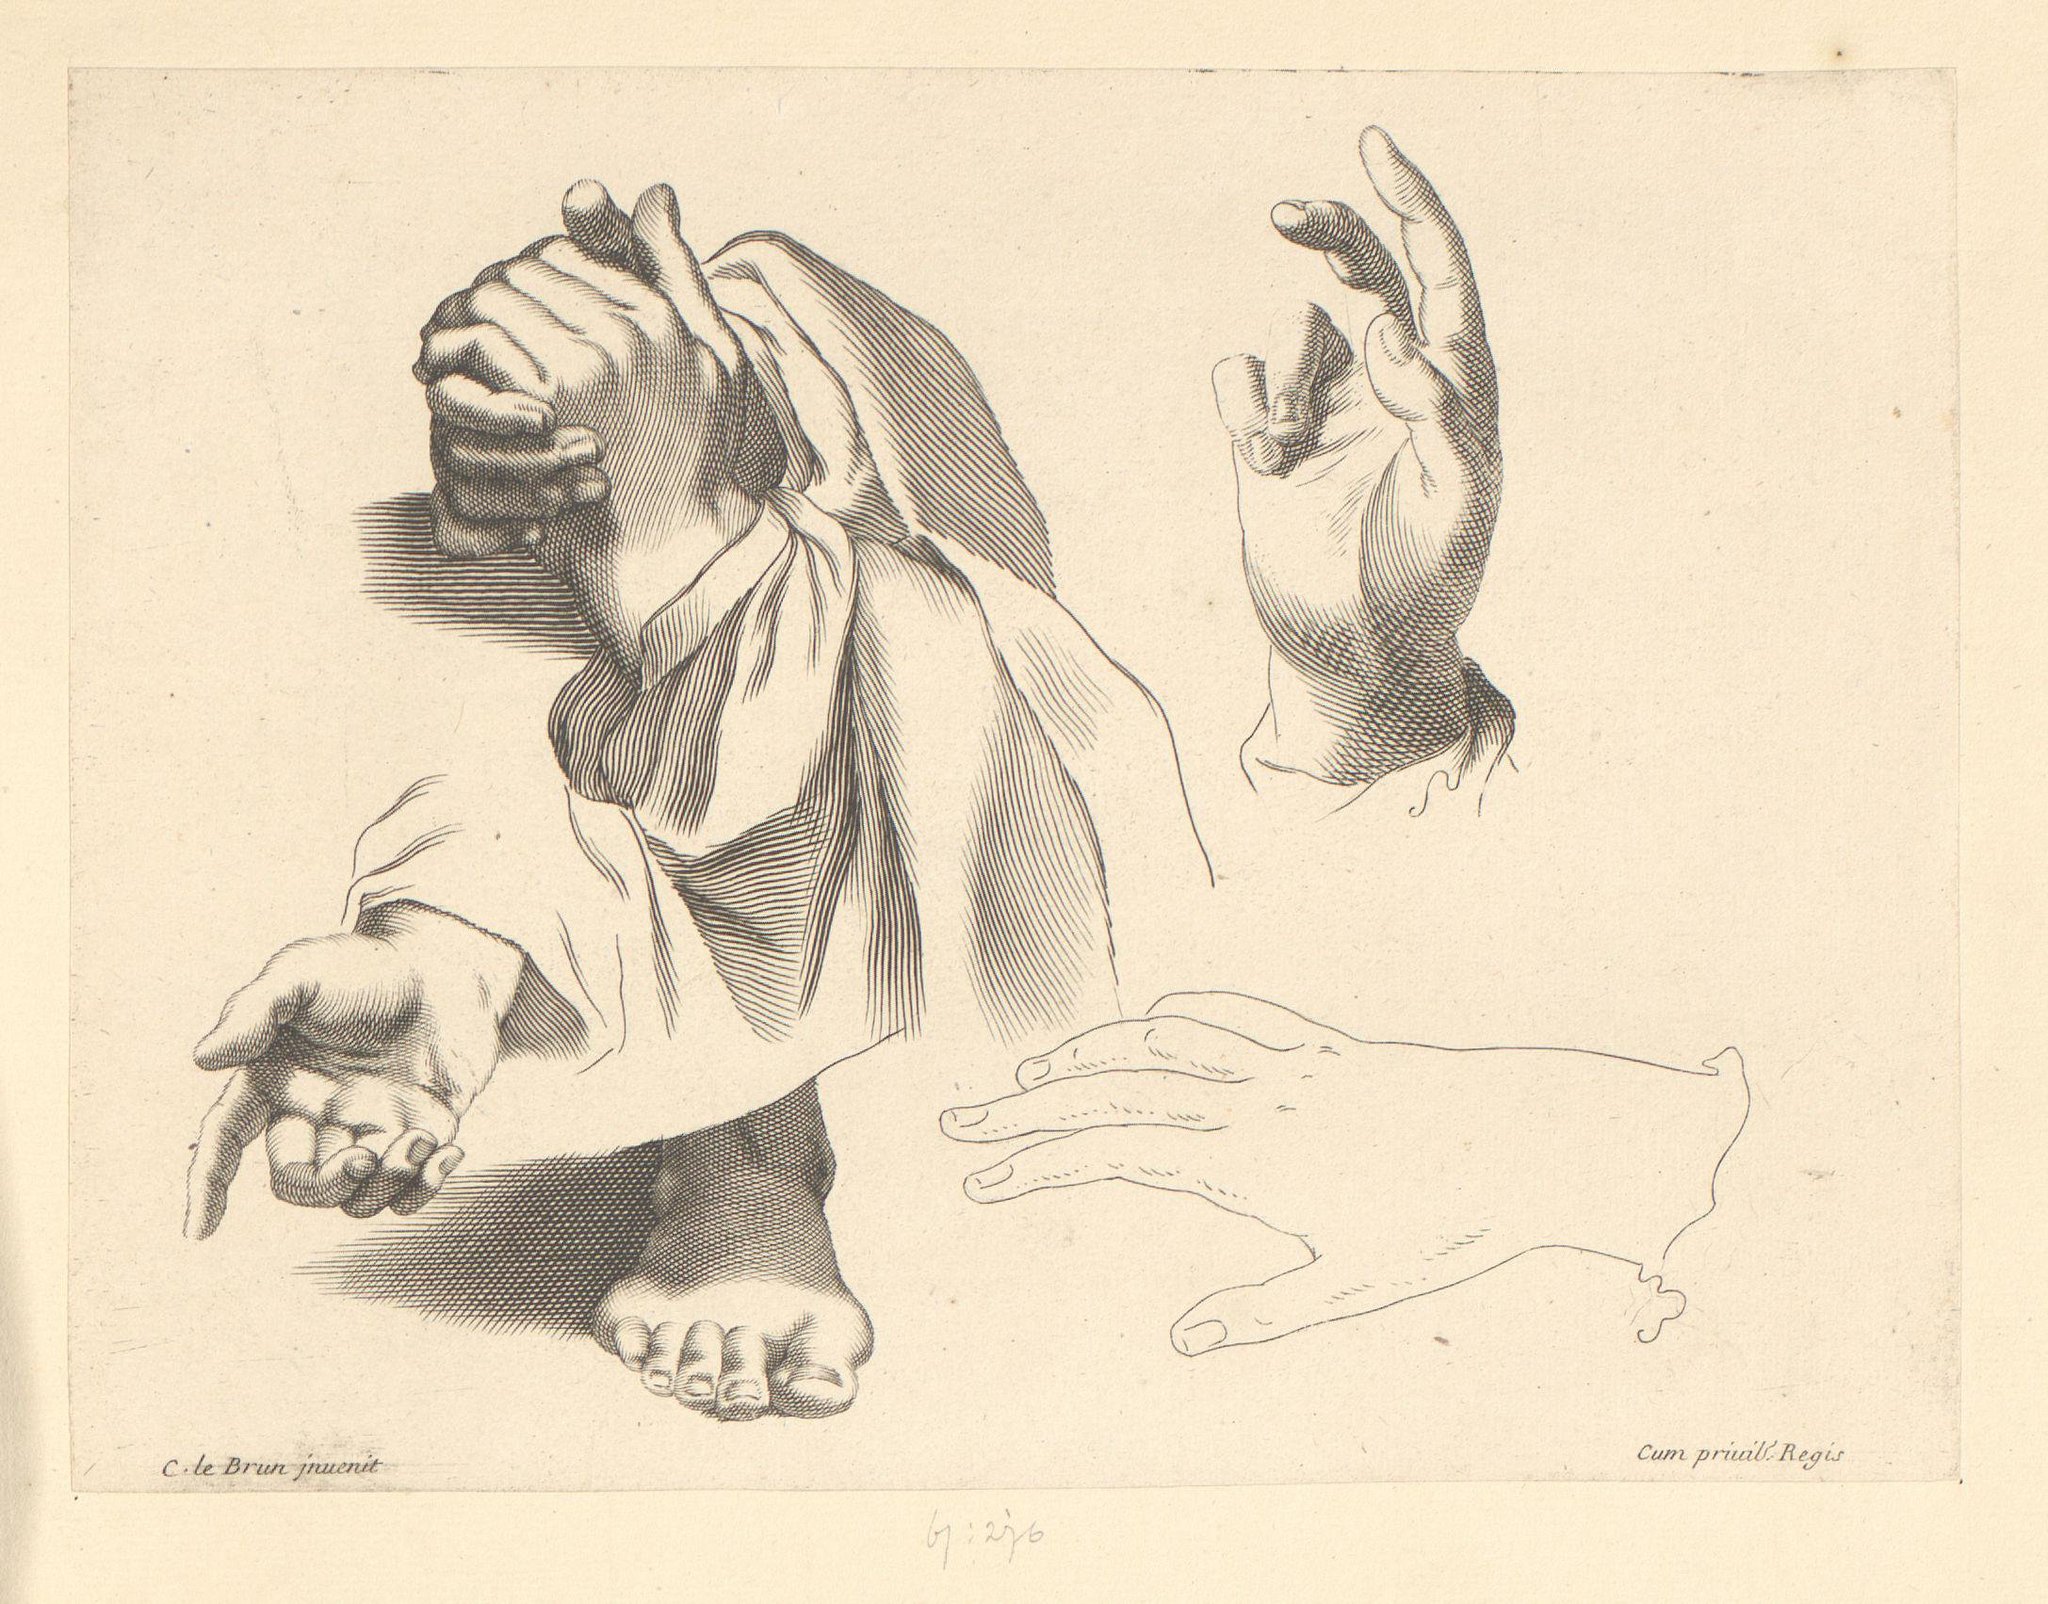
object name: print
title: Studies van handgebaren en een voet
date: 1700-1725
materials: paper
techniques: etching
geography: paris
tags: postures and gestures of hand and fingers, foot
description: Deze prent maakt deel uit van de serie 'Livre de portraiture', die weer onderdeel is van de grotere reeks 'Oeuvre de Charles le Brun'.